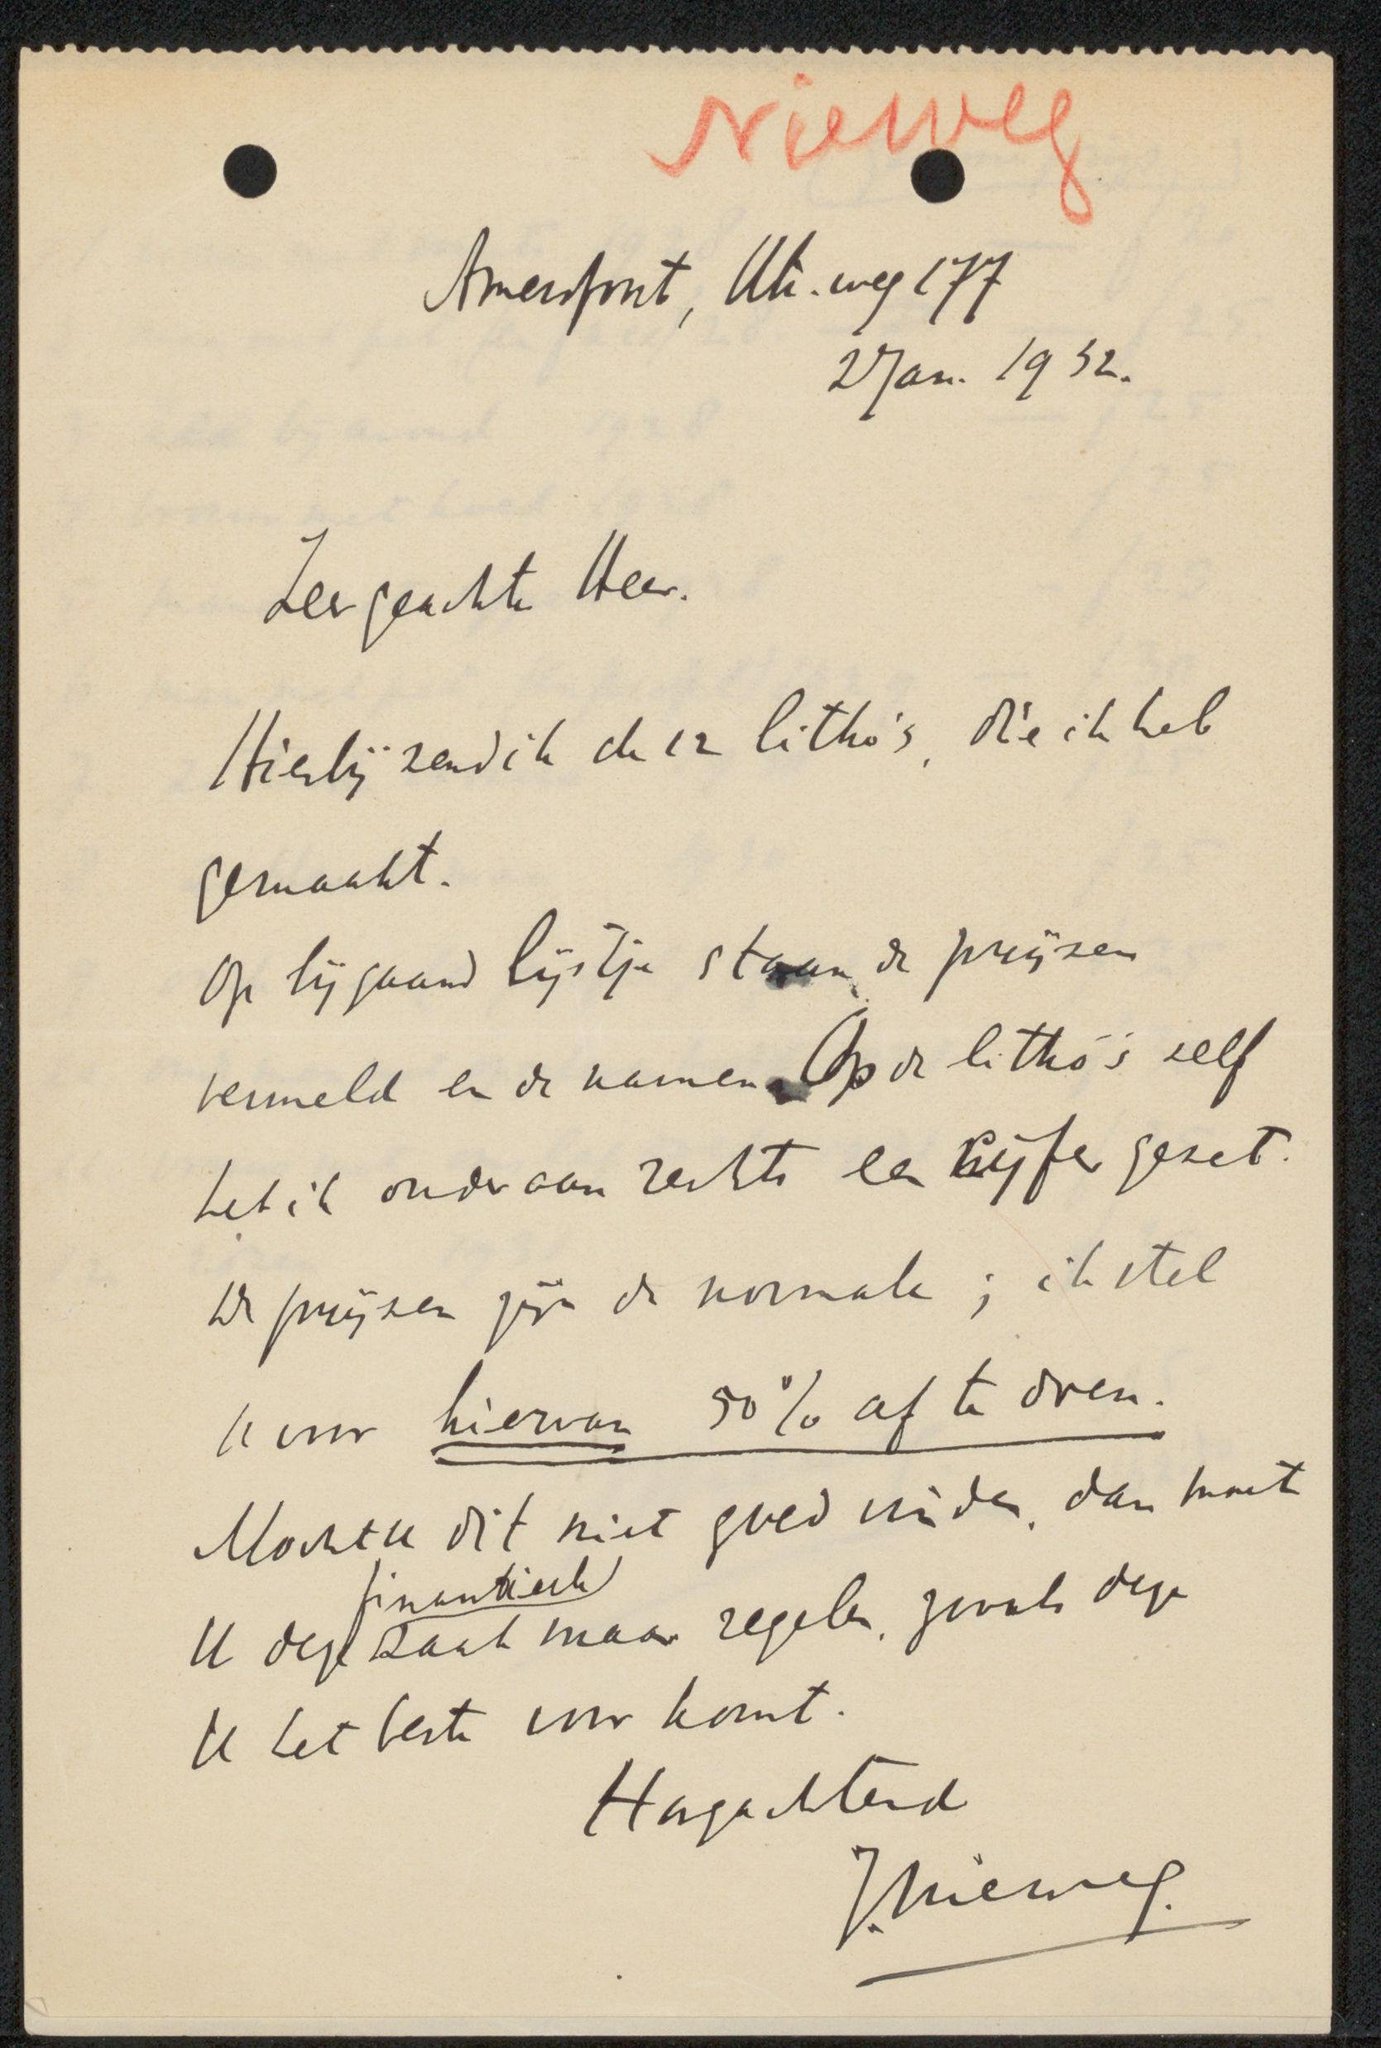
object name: letter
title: Brief aan jonkheer Hendrik Teding van Berkhout (1879-1969)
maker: jakob nieweg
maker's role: draughtsman, print maker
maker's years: 1877-1955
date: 1932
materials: ink, paper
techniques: pen, writing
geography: amersfoort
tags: haarlem, amsterdam, jonkheer hendrik teding van berkhout (1879-1969), the graphic arts, art collecting, money